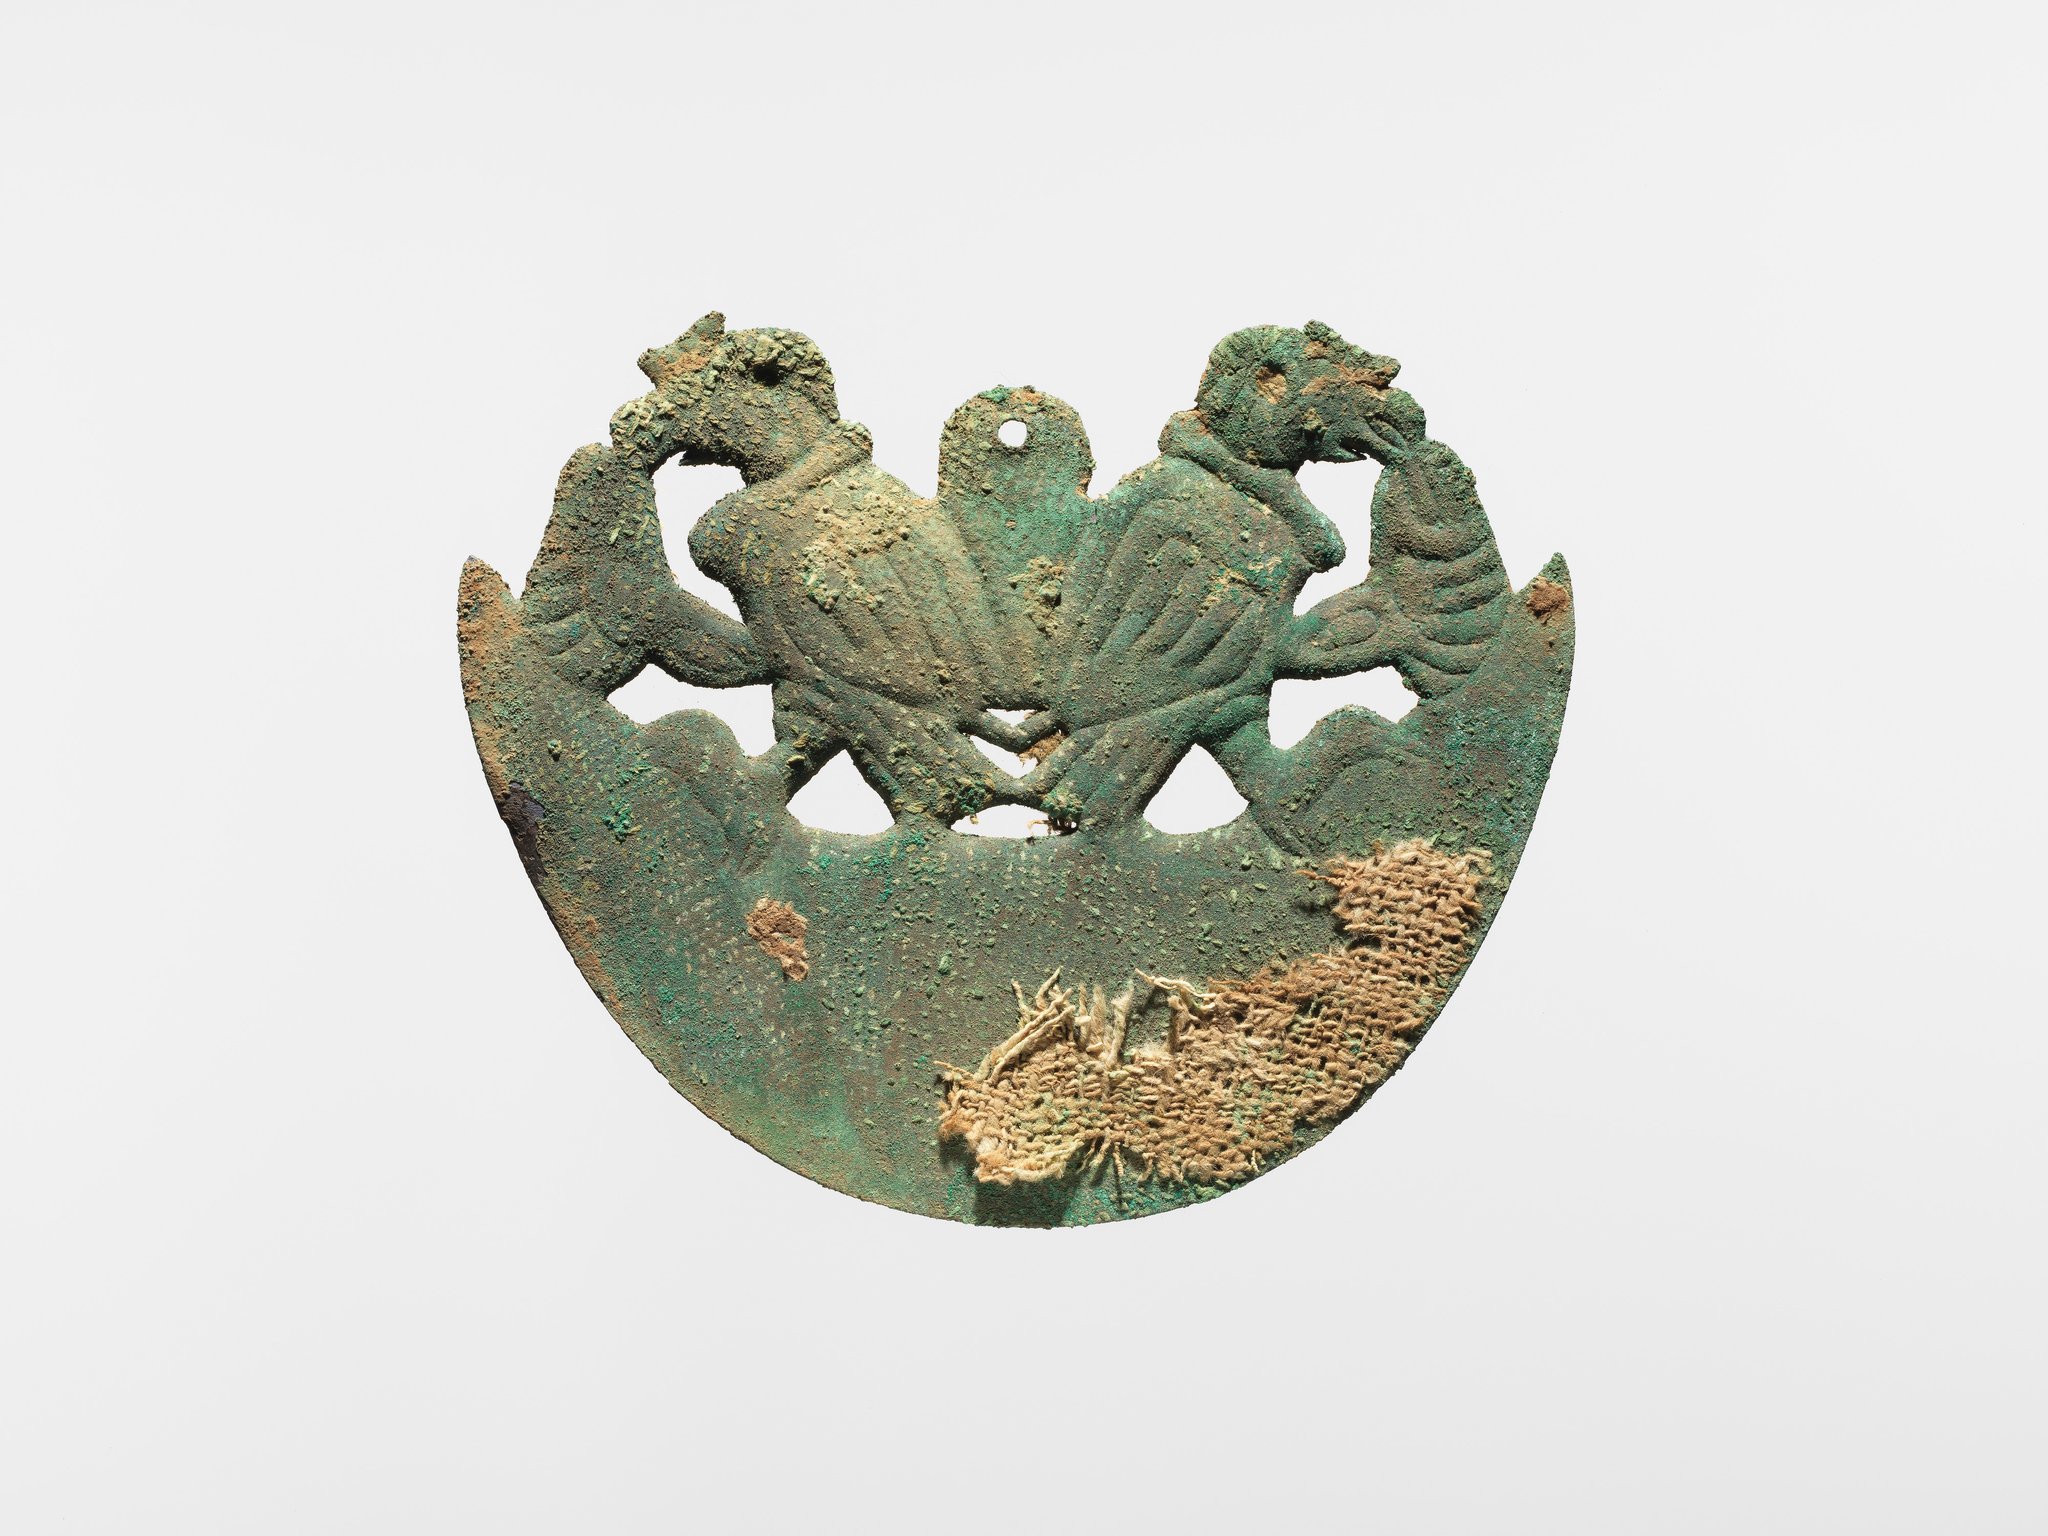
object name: ornament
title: Animal Ornament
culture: moche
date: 501-700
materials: gilt copper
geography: peru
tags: birds